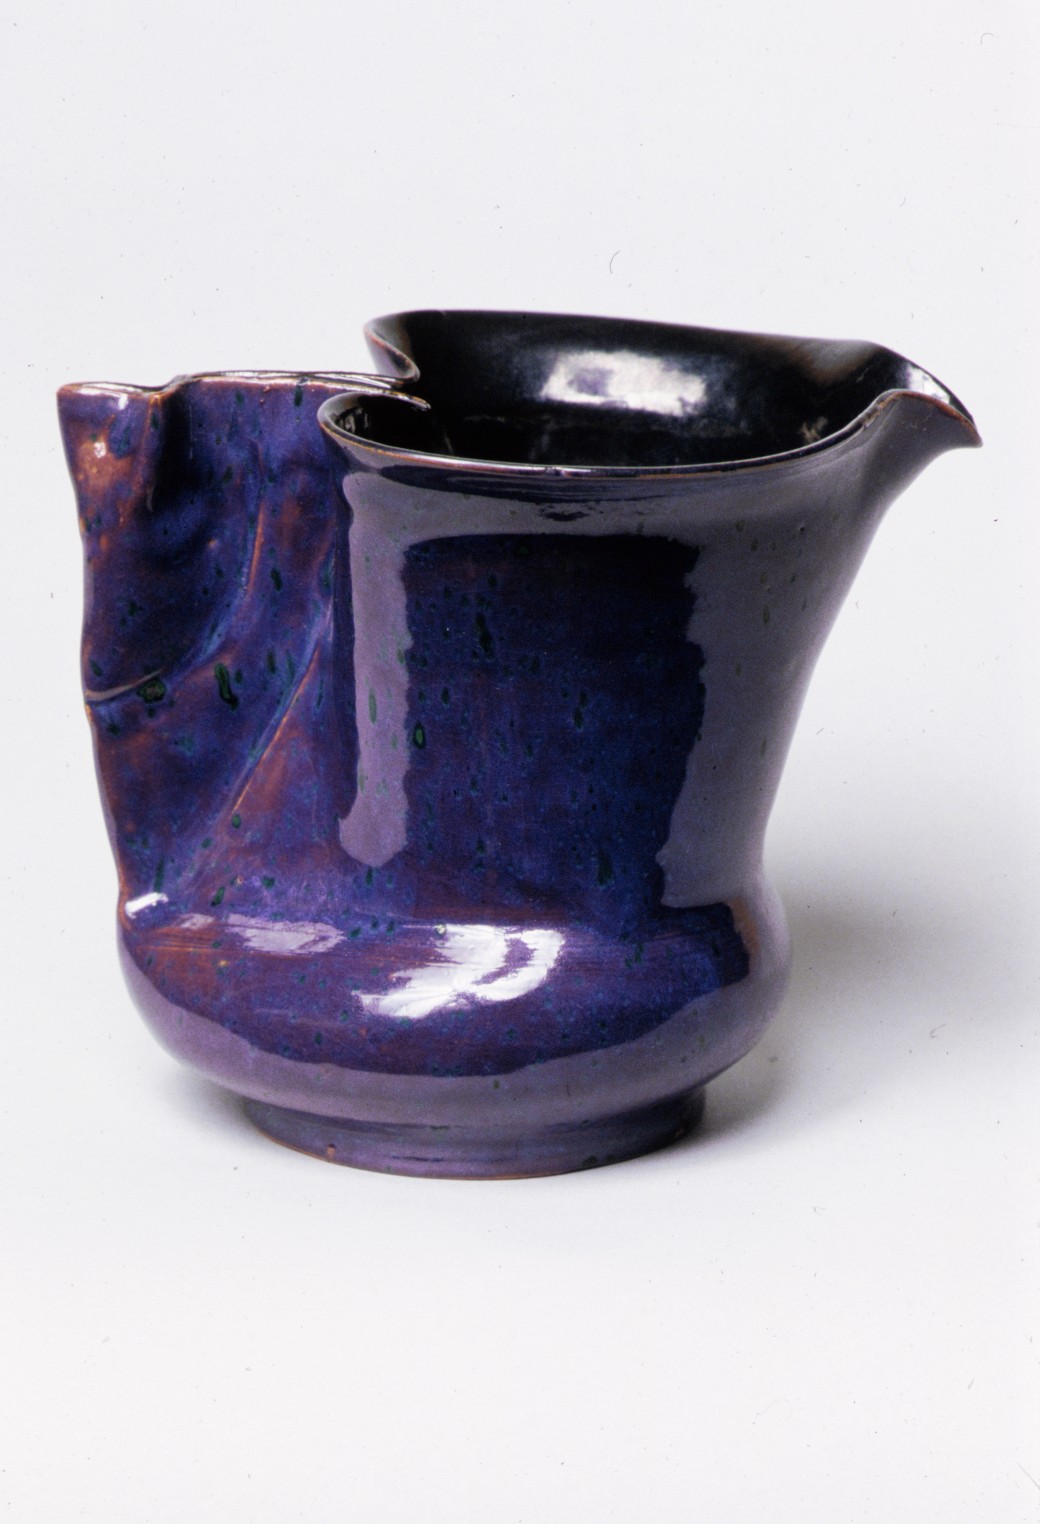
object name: pitcher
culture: american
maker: george e. ohr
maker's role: maker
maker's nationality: american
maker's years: 1857-1918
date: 1893-1909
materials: earthenware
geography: united states